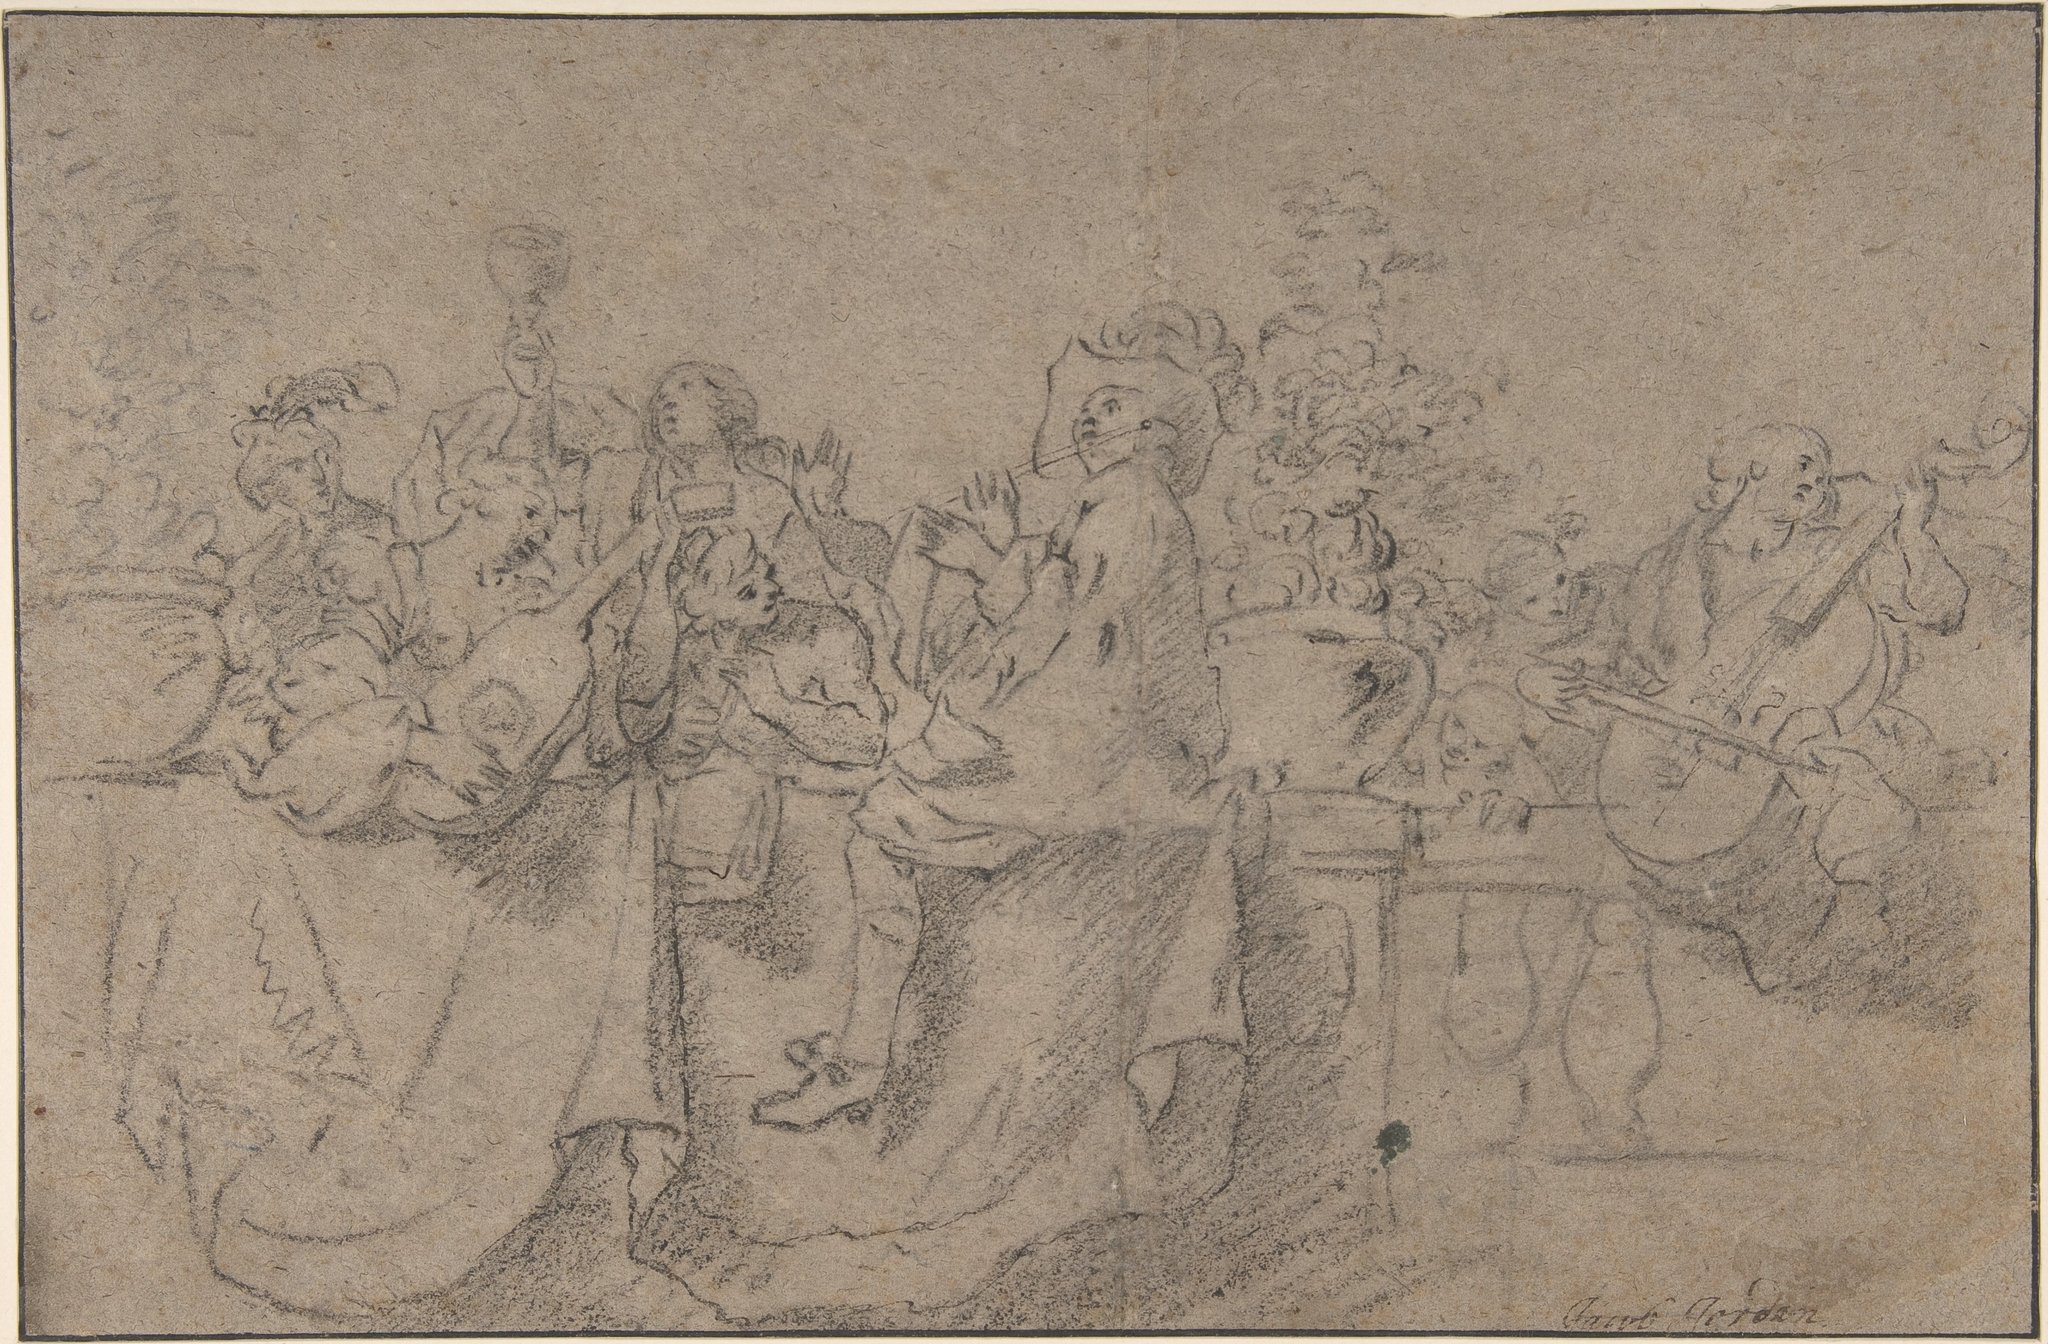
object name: drawing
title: Recto: The Concert Verso: Seated Male Nude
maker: johann liss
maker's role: artist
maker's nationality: german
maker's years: 1595-1631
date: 1601-1633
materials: chalk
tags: men,concerts,music,cellos,flutes